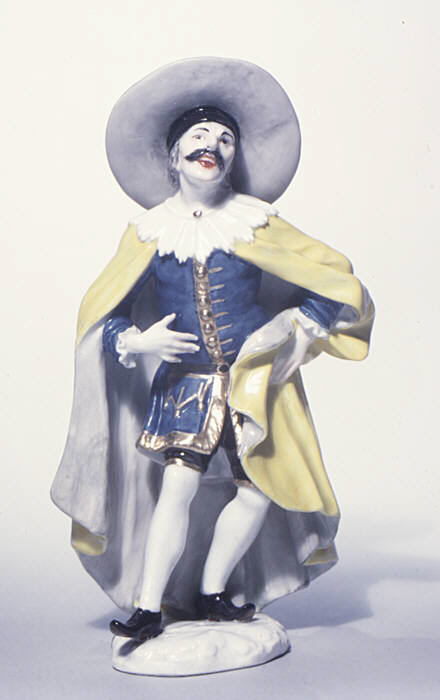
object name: figure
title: Doctor Boloardo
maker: meissen manufactory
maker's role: manufactory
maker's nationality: german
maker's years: 1710-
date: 1738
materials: hard paste porcelain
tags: men